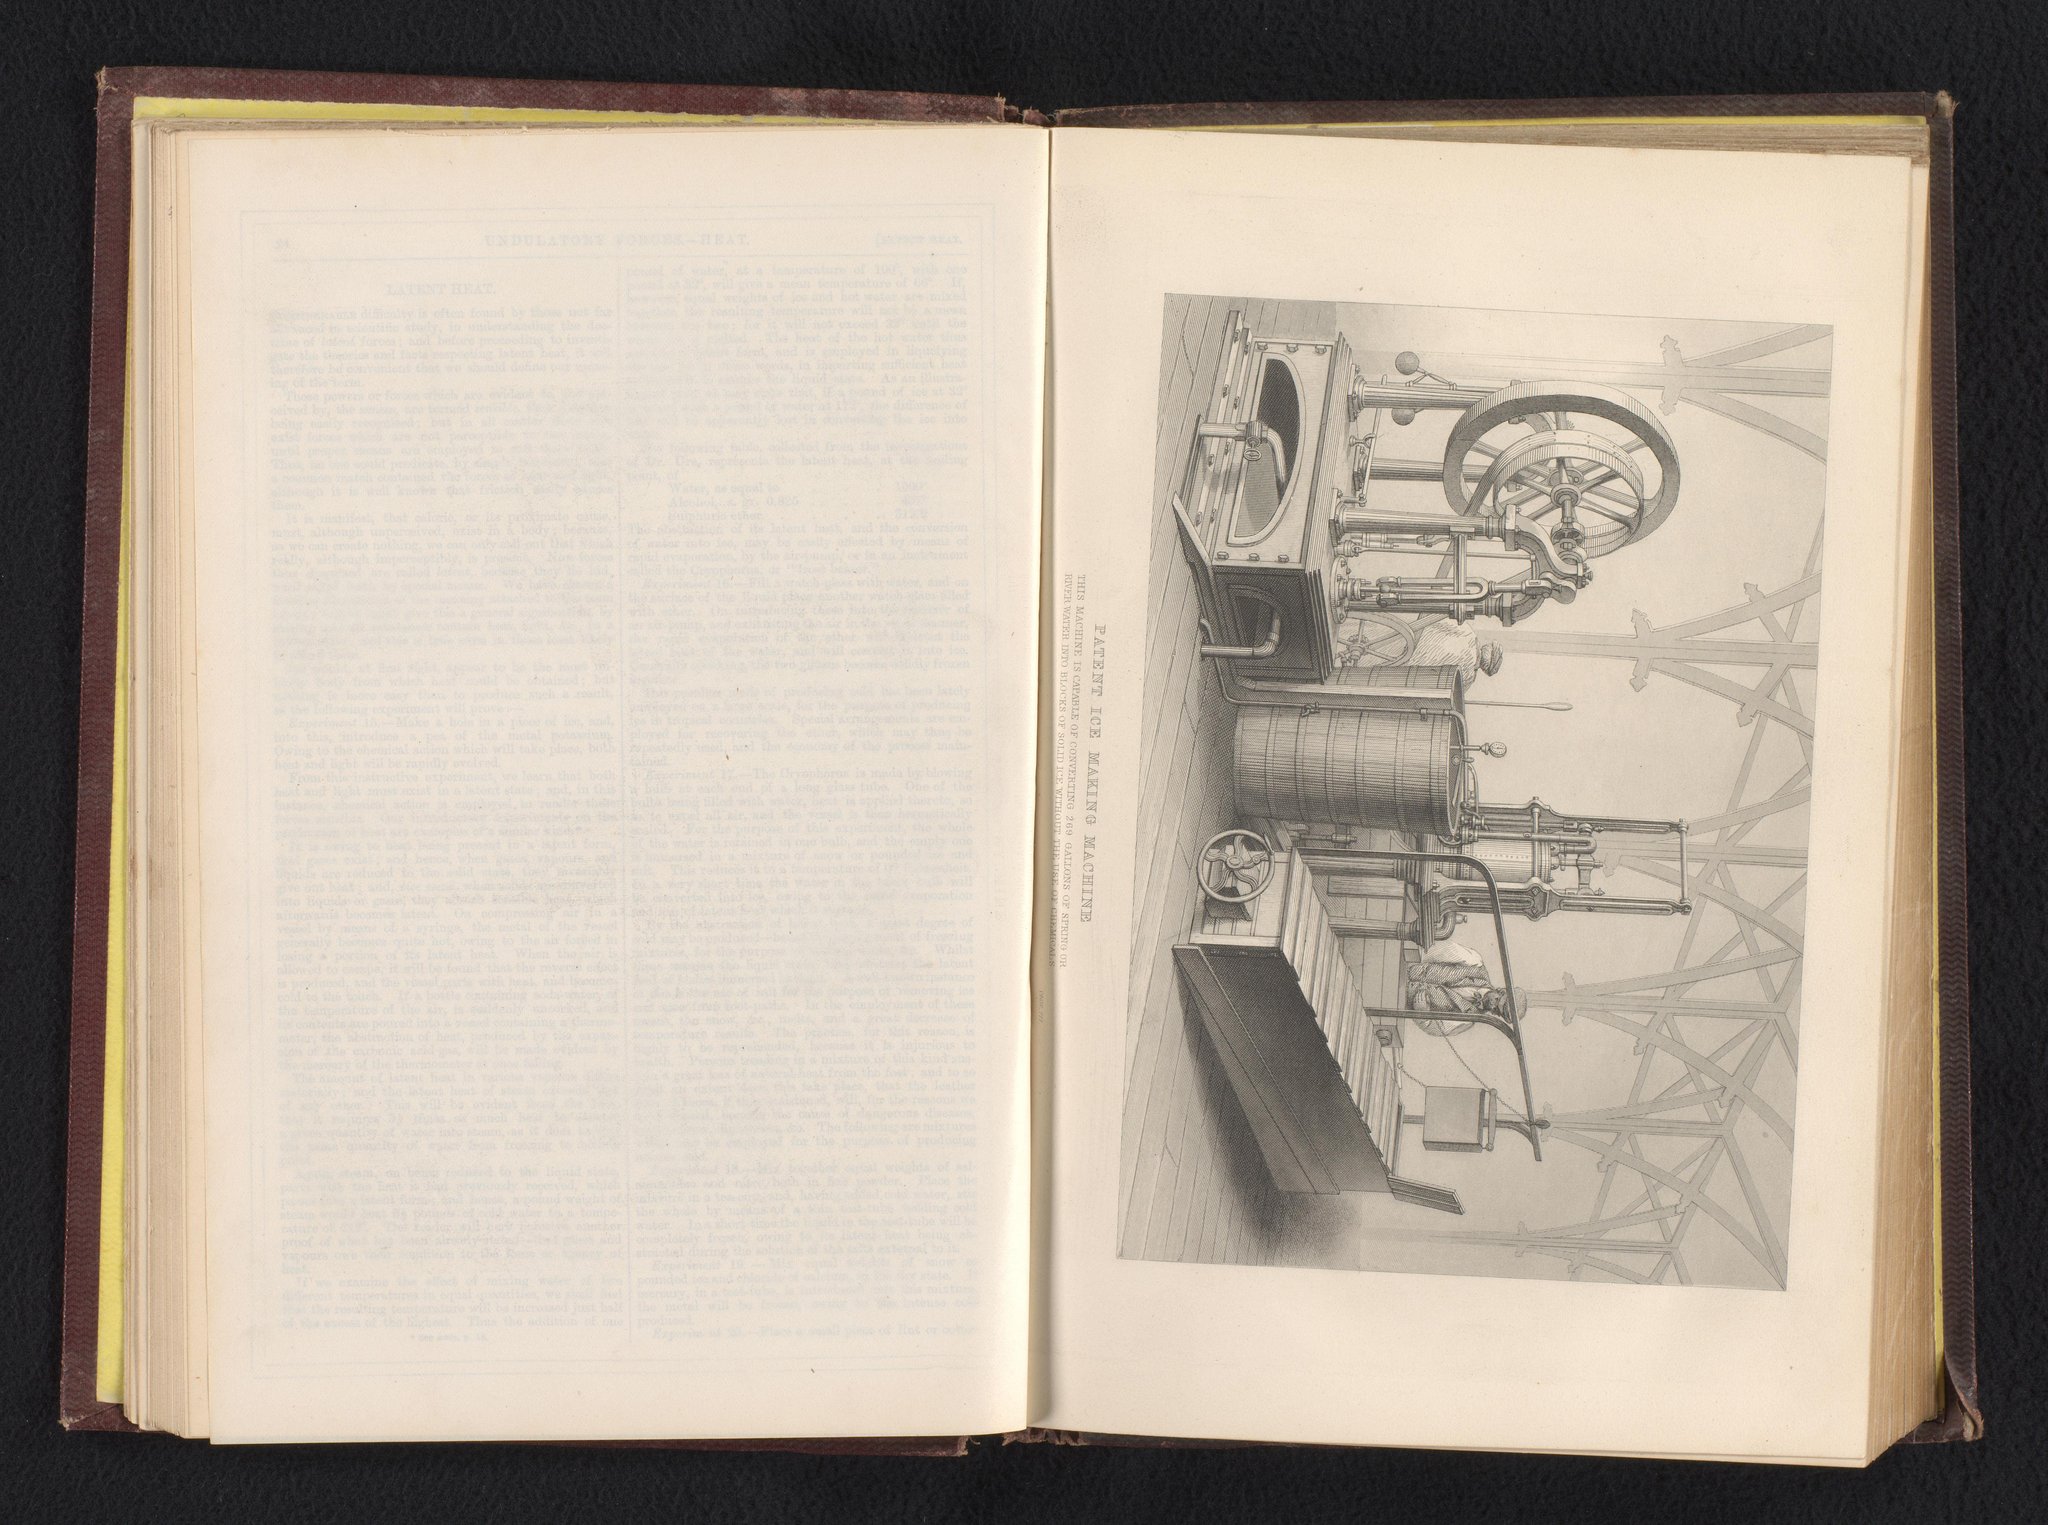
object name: page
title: Patent ice making machine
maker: Anonymous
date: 1856-1861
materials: paper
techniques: engraving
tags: machines; parts of machines; tools and appliances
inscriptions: inscription: ‘THIS MACHINE IS CAPABLE OF CONVERTING 269 GALLONS OF SPRING OR/ RIVER WATER INTO BLOCKS OF SOLID ICE WITHOUT THE USE OF CHEMICALS. / PAGE 777’